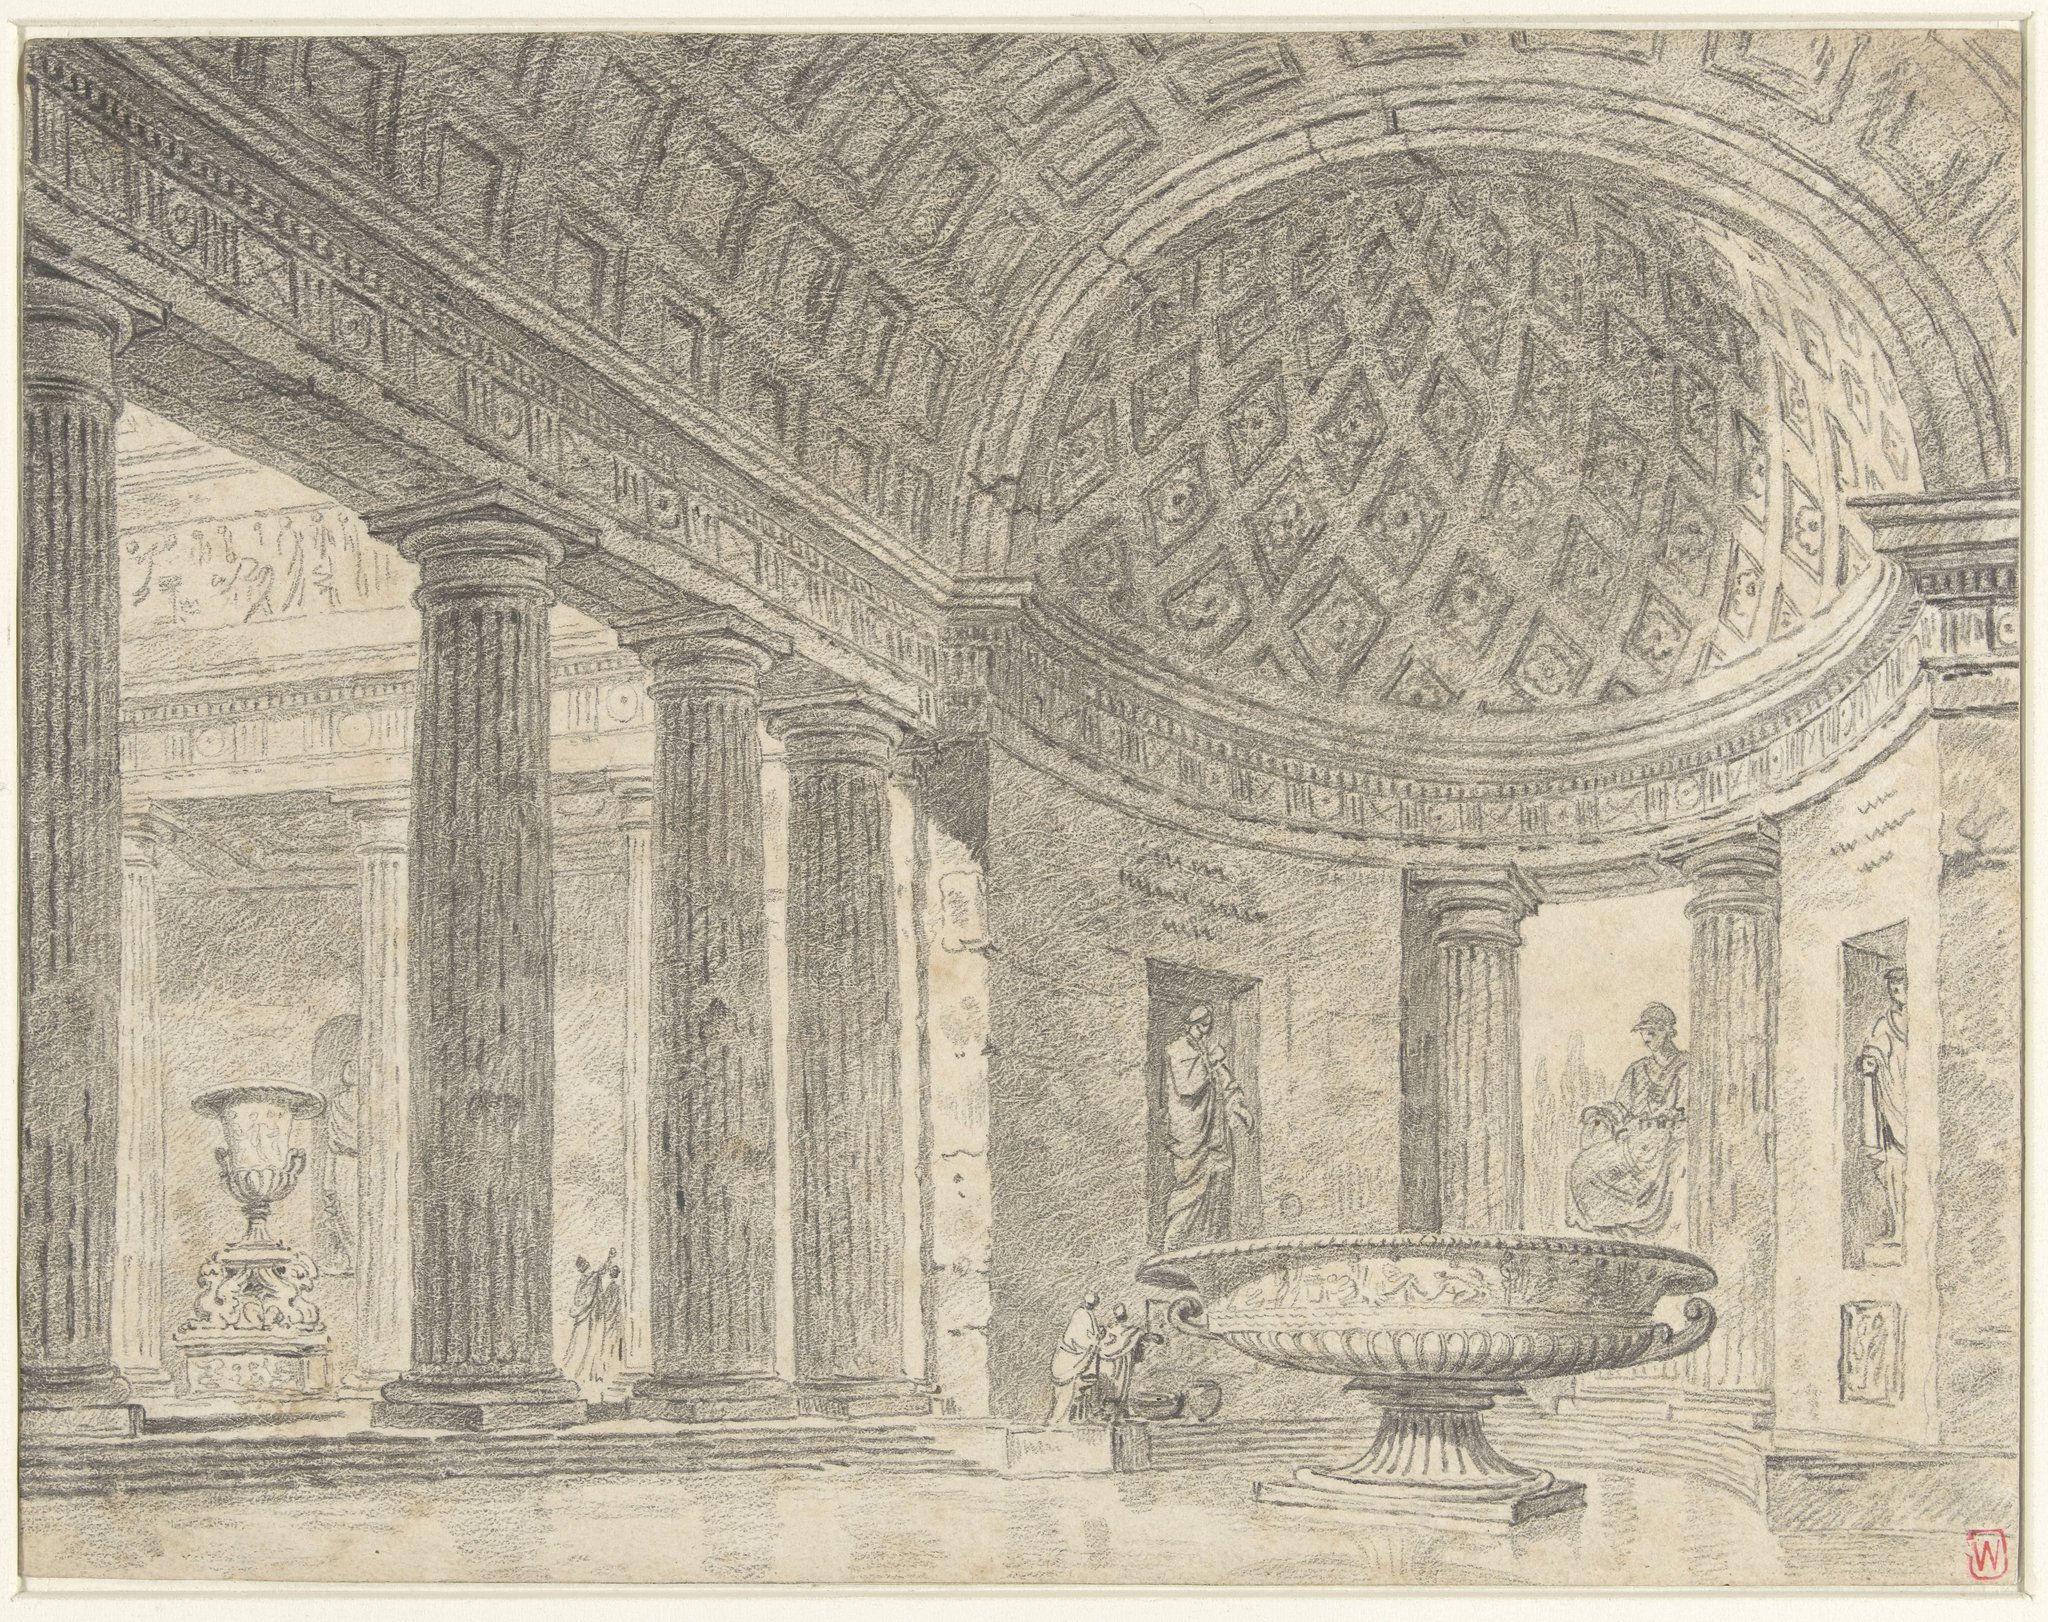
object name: drawing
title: Villa Albani te Rome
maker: hubert robert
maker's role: draughtsman, print maker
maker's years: 1733-1808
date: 1754-1808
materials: chalk, paper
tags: palace - aa - civic architecture: inside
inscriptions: annotation, verso, lower left, pencil: ‘38’, collector's mark, verso, lower centre: Lugt 2228, annotation, verso, lower right, pencil: ‘467’, annotation, verso, centre, pencil: ‘Villa Albani Rome / de St Non’, annotation, verso, upper left, pencil: ‘A8 1/38 [?]’, collector's mark, recto, lower right: Lugt 1552b, annotation, verso, upper right, pencil: ‘19/32 [doorgestreept]’, annotation, verso, upper centre, pencil: ‘10’